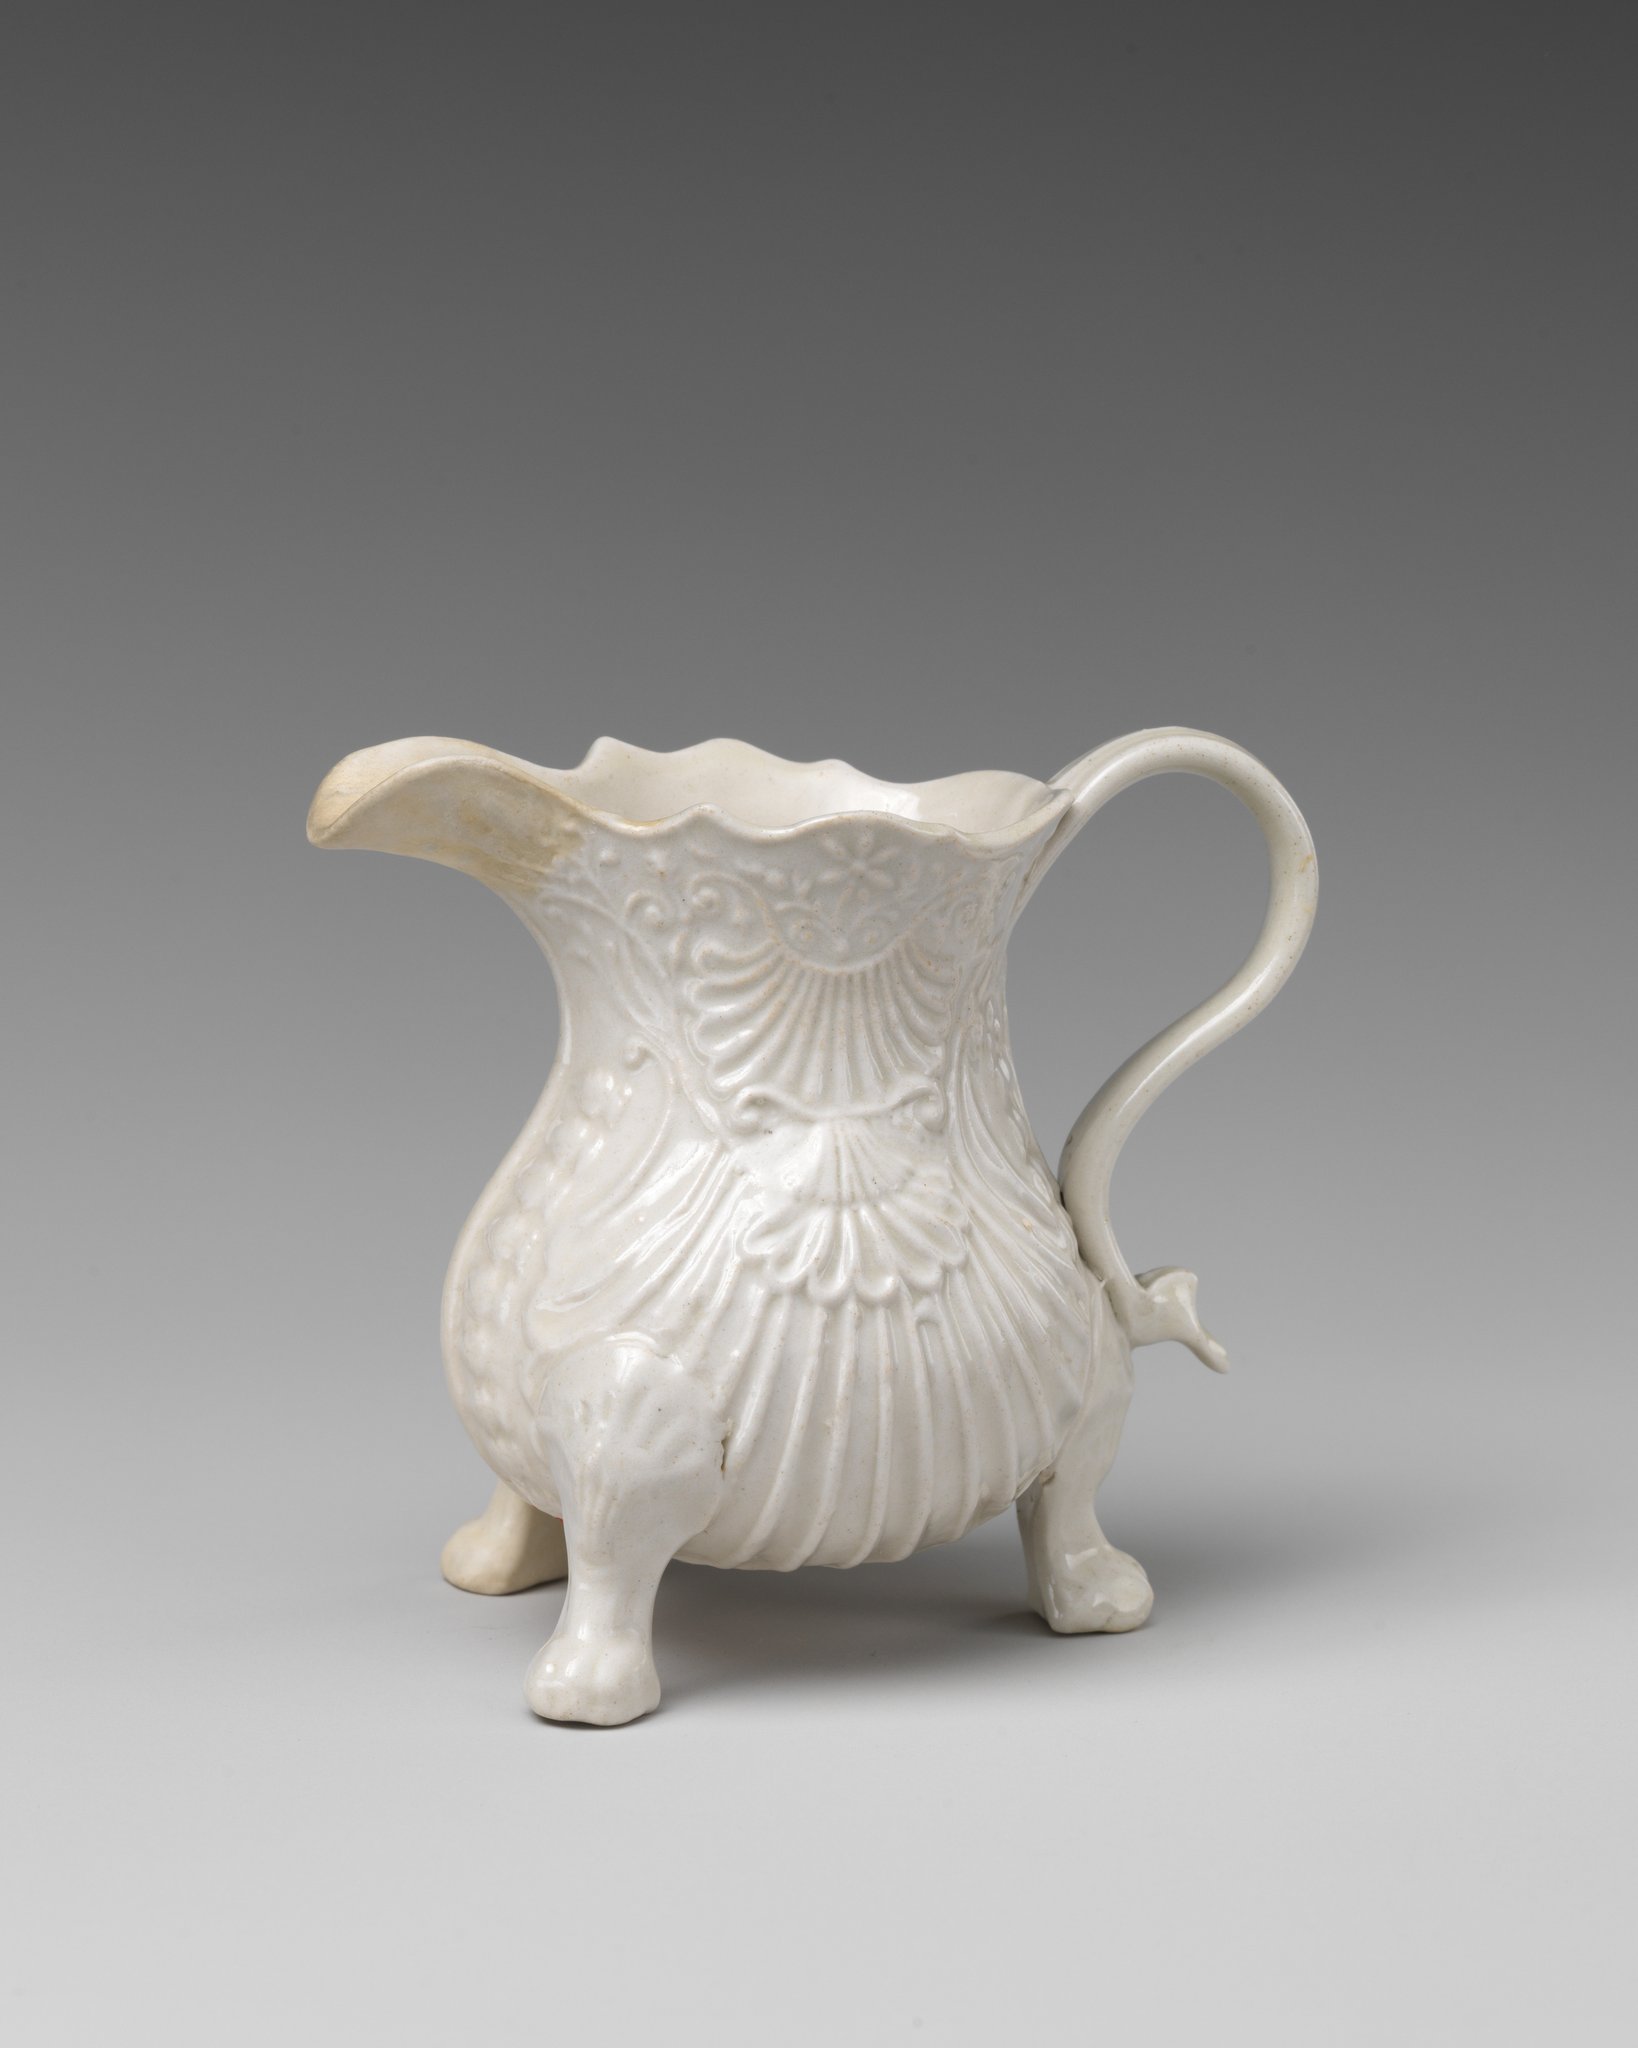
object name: cream jug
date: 1750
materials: stoneware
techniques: salt glaze